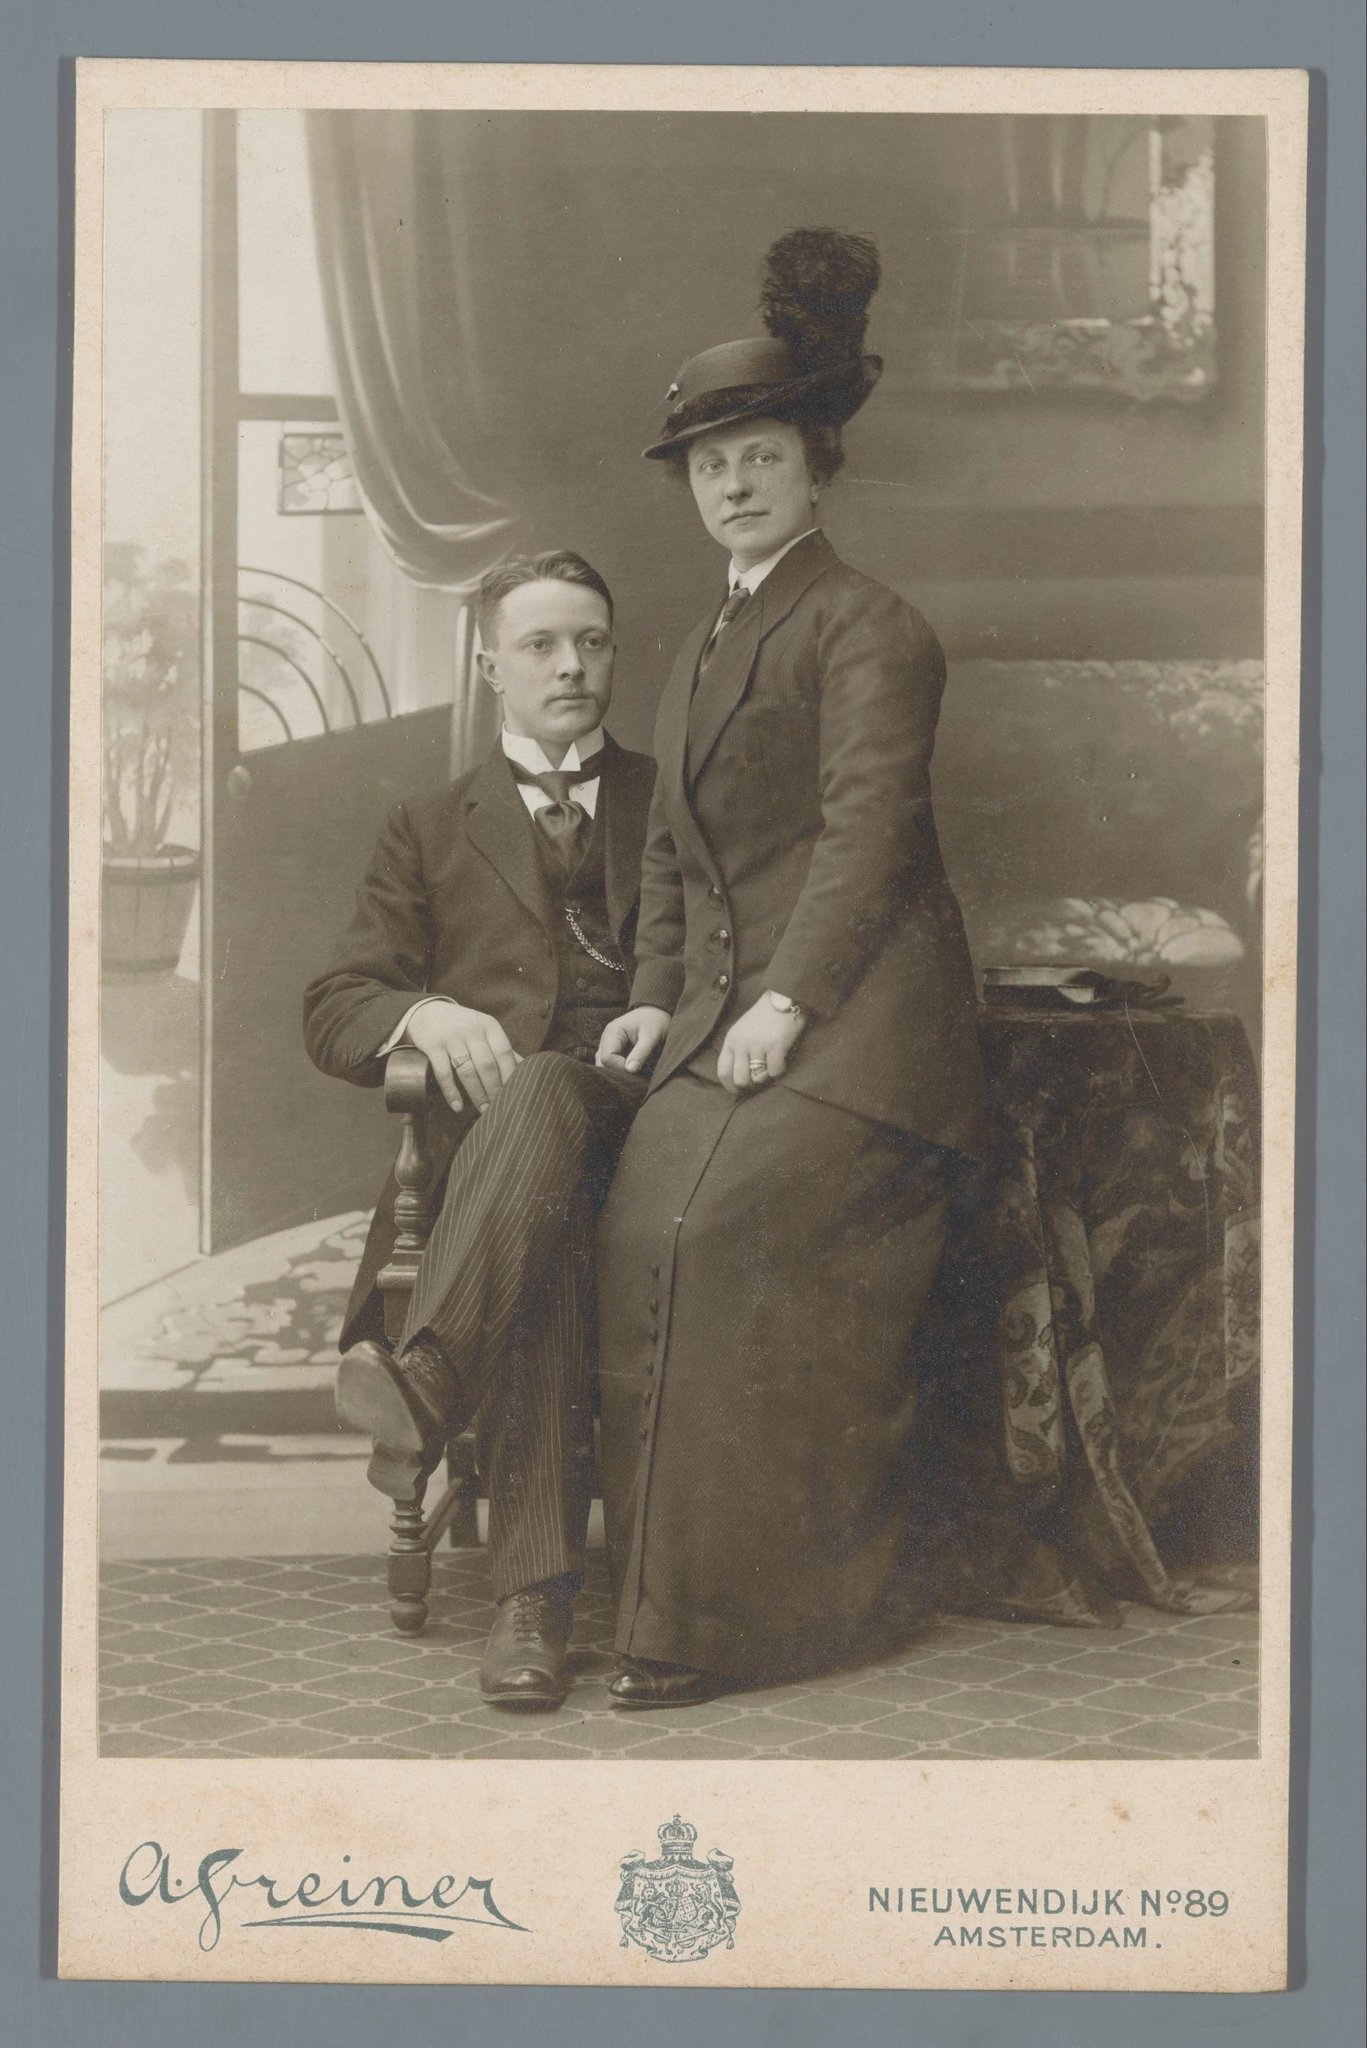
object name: cabinet photograph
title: Portret van een onbekende vrouw op schoot bij een onbekende man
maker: albert greiner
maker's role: fotograaf, fotostudio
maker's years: 1833-1890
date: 1883-1890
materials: cardboard, photographic support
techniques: gelatin silver print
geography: amsterdam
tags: adult woman, studio requisites ~ photographer, sitting in someone's lap - aa - female human figure, adult man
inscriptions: name: ‘No 46545. Albert Greiner Fotograaf van wijlen Z.M. den Koning Willem III en van H.M. de Koningin Weduwe (...)’